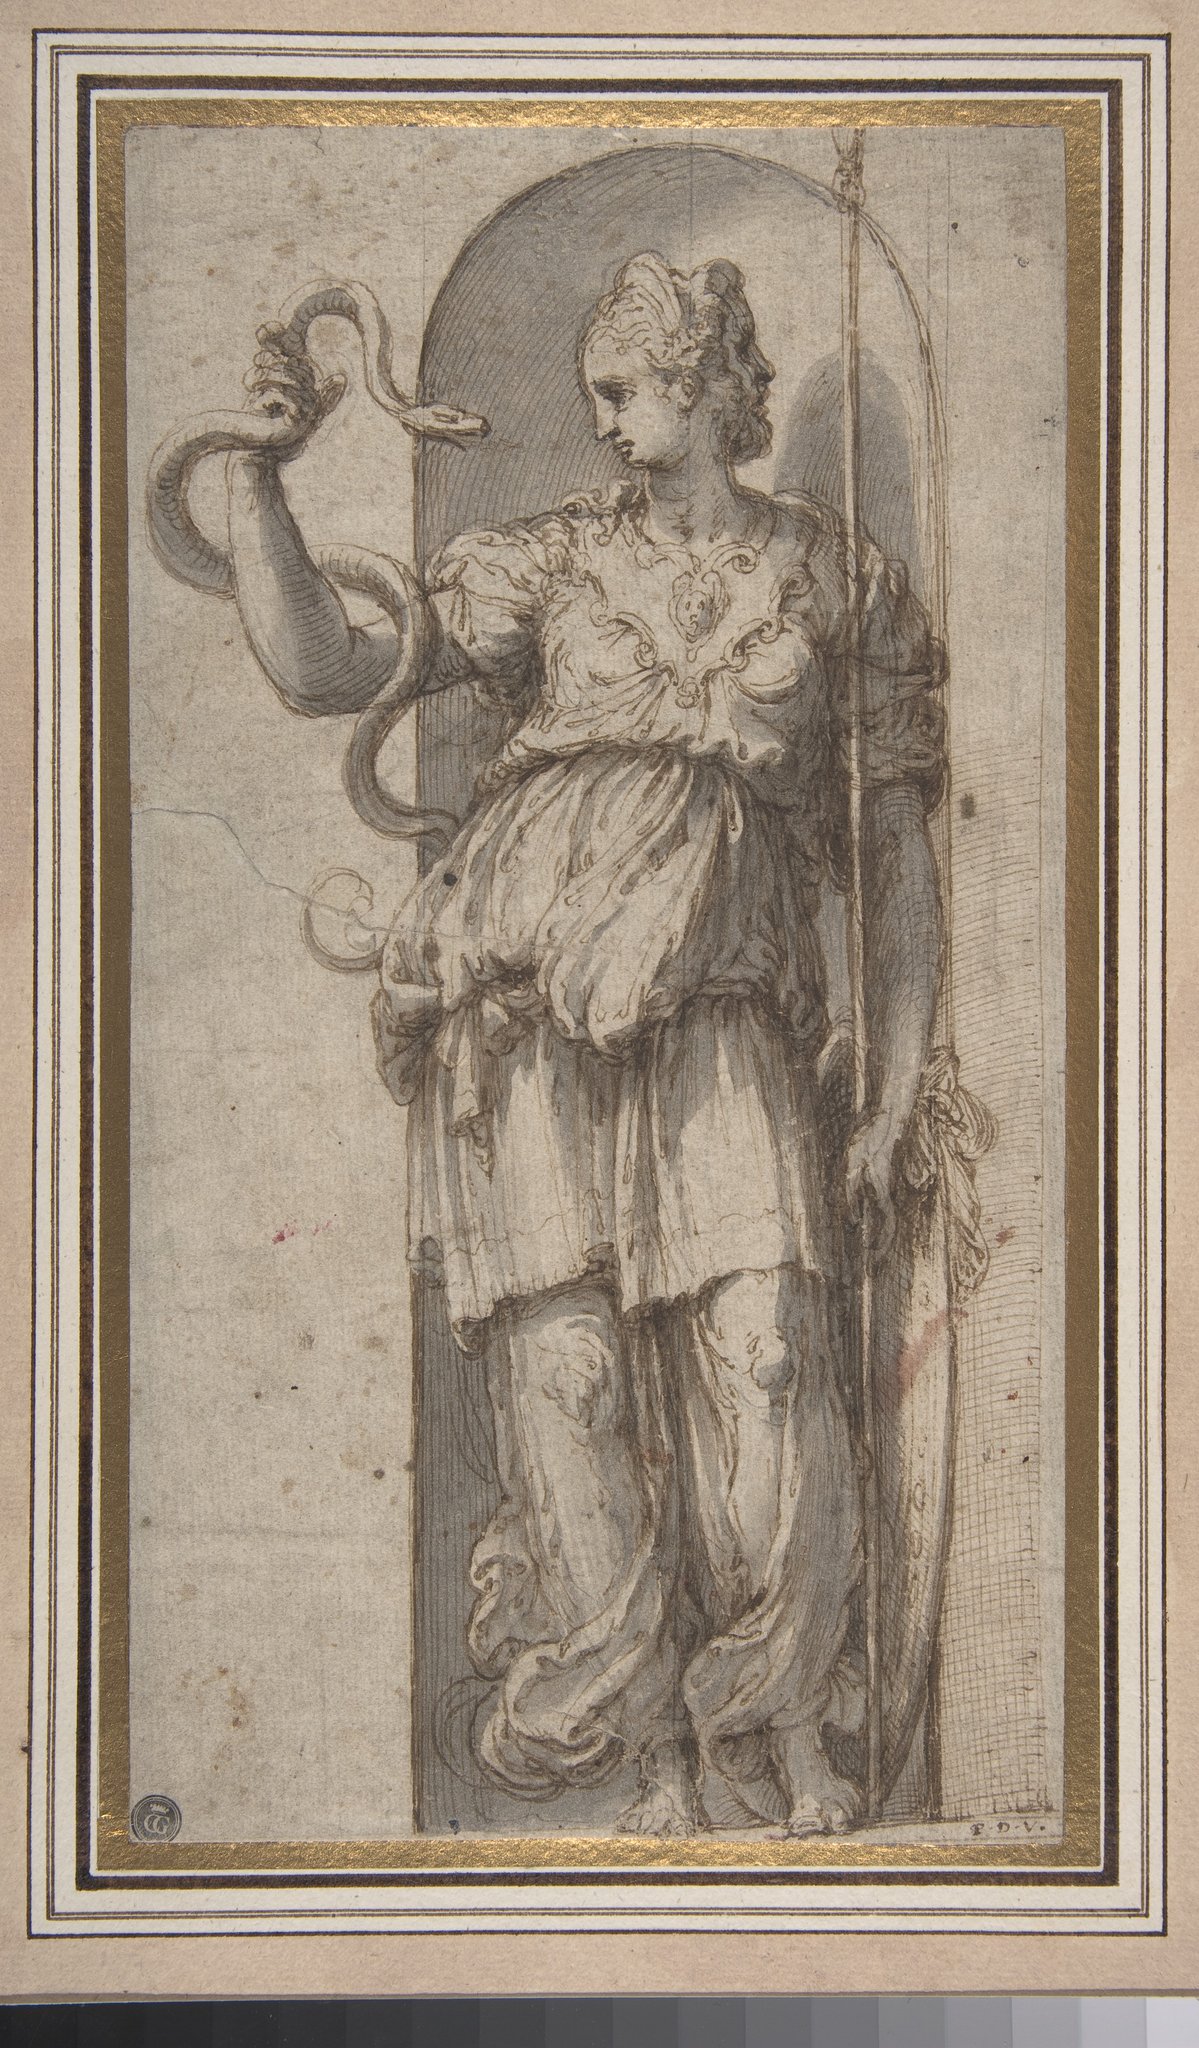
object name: drawing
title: Study for Allegorical Figure of Prudence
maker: perino del vaga (pietro buonaccorsi)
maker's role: artist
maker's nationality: italian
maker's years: 1501-1547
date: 1501-1547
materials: chalk, ink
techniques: brush, pen, wash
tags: women,snakes